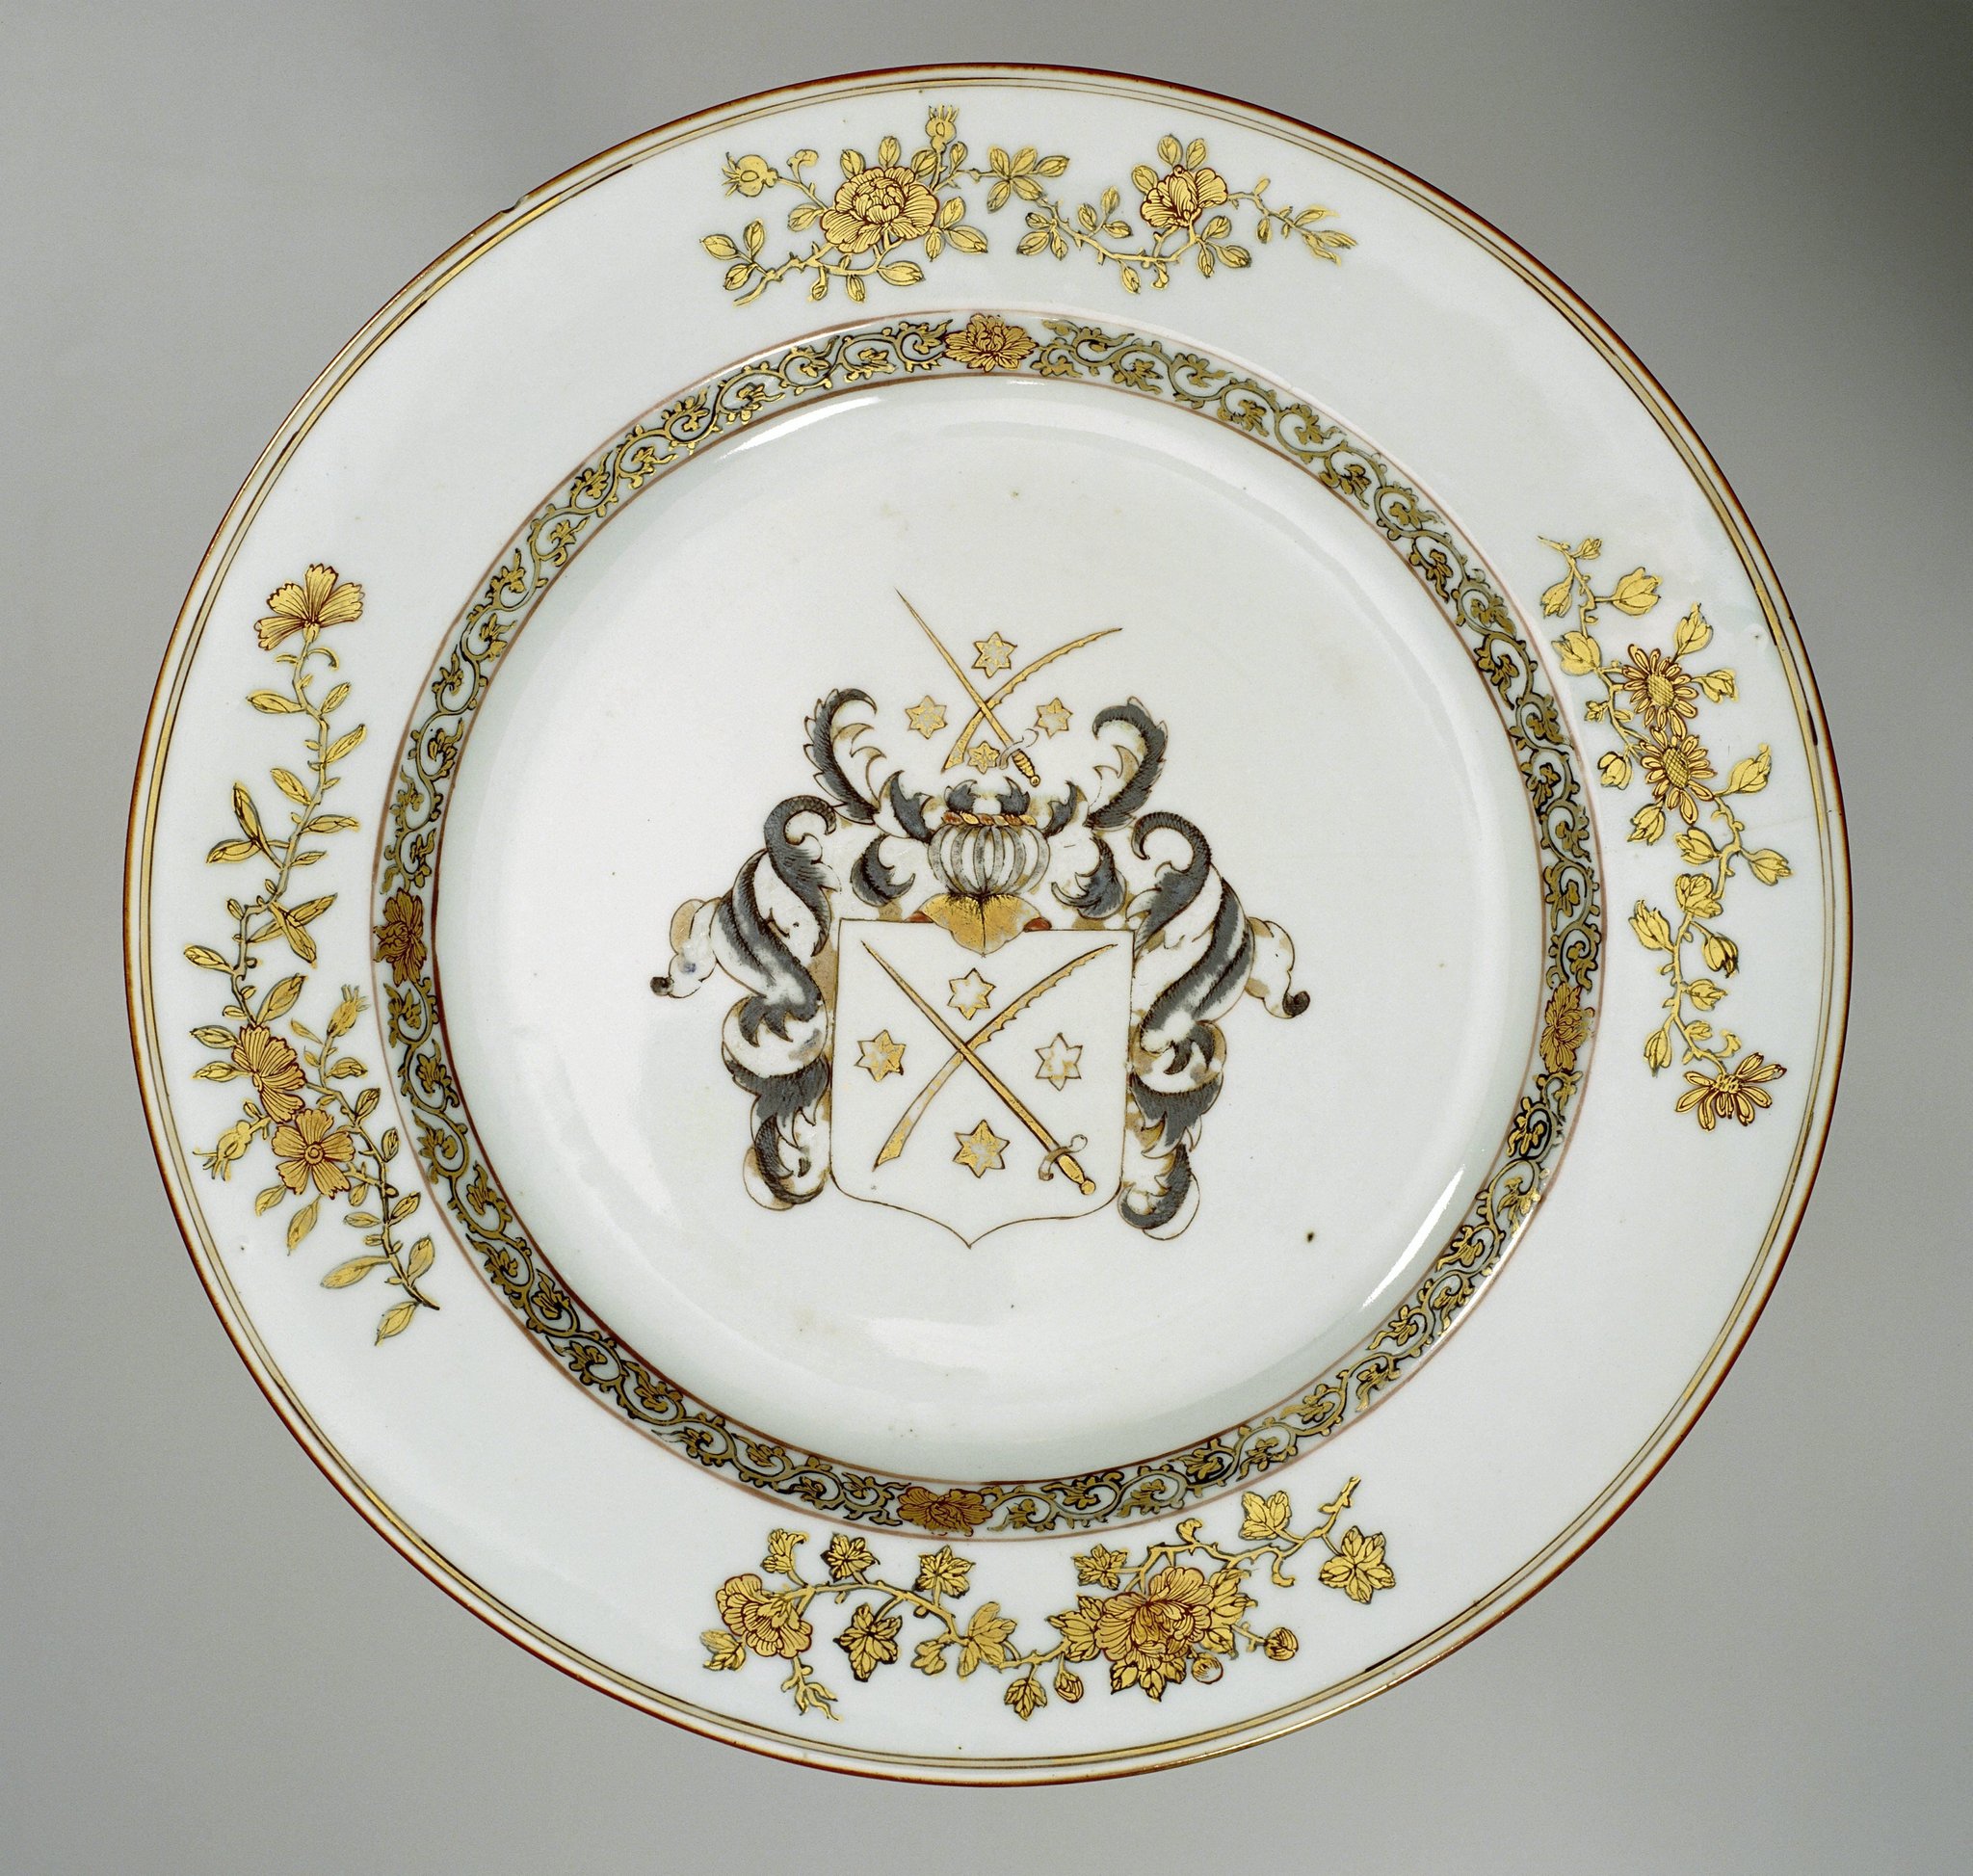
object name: plate dish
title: Plate with the arms of the Bijnkershoek family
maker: Anonymous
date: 1735-1740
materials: glaze, gold, paint, porcelain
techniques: firing, gilding, turning, vitrification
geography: china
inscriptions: label: ‘van Bynkershoek’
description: Bord van porselein, beschilderd op het glazuur in rood, zwart en goud. Op het plat het wapen van de familie Bijnkershoek. Het wapen en helmteken bestaan uit een gouden zwaard en veer of slagpen met sterren. Het dekkleed bestaat uit bladeren in zwart of zilver en goud. Op de wand een band met bloemranken; de rand met vier bloemtakken (aster, pioen, prachtanjer). Oud label op de onderzijde met 'van Bynkershoek'. Een barst en een chip in de rand. Wapenporselein min encre de Chine.